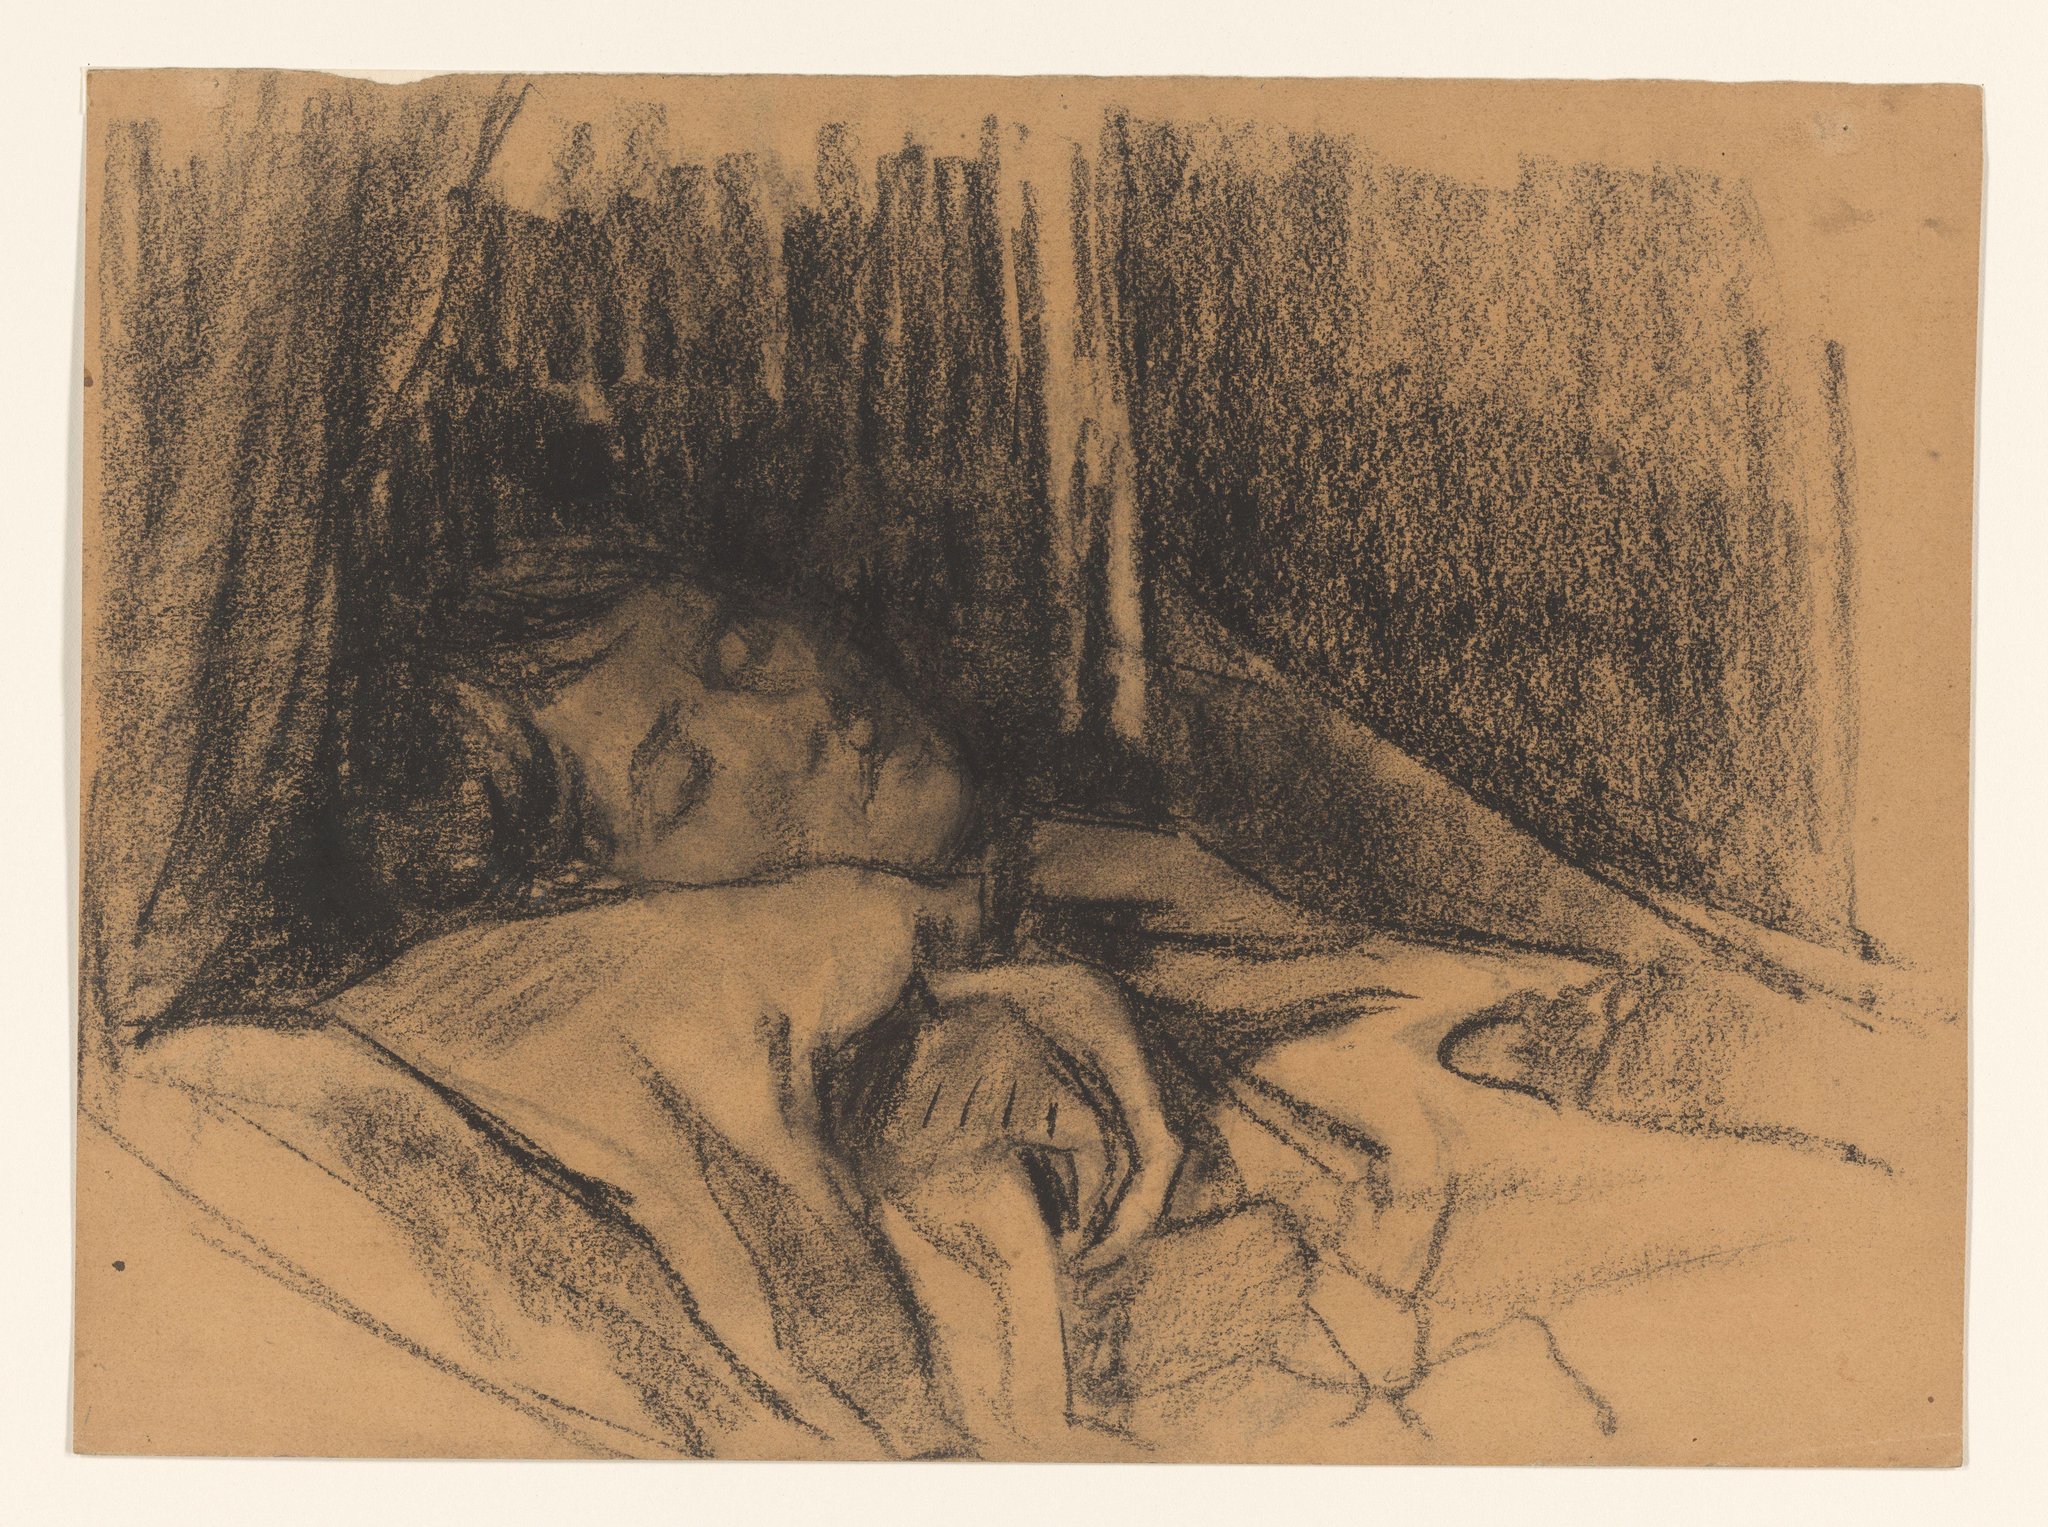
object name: drawing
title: Vrouw van Wilhelmus Johannes Steenhoff, in bed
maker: wilhelmus johannes steenhoff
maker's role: draughtsman, print maker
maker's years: 1863-1932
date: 1873-1932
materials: chalk, paper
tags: historical persons